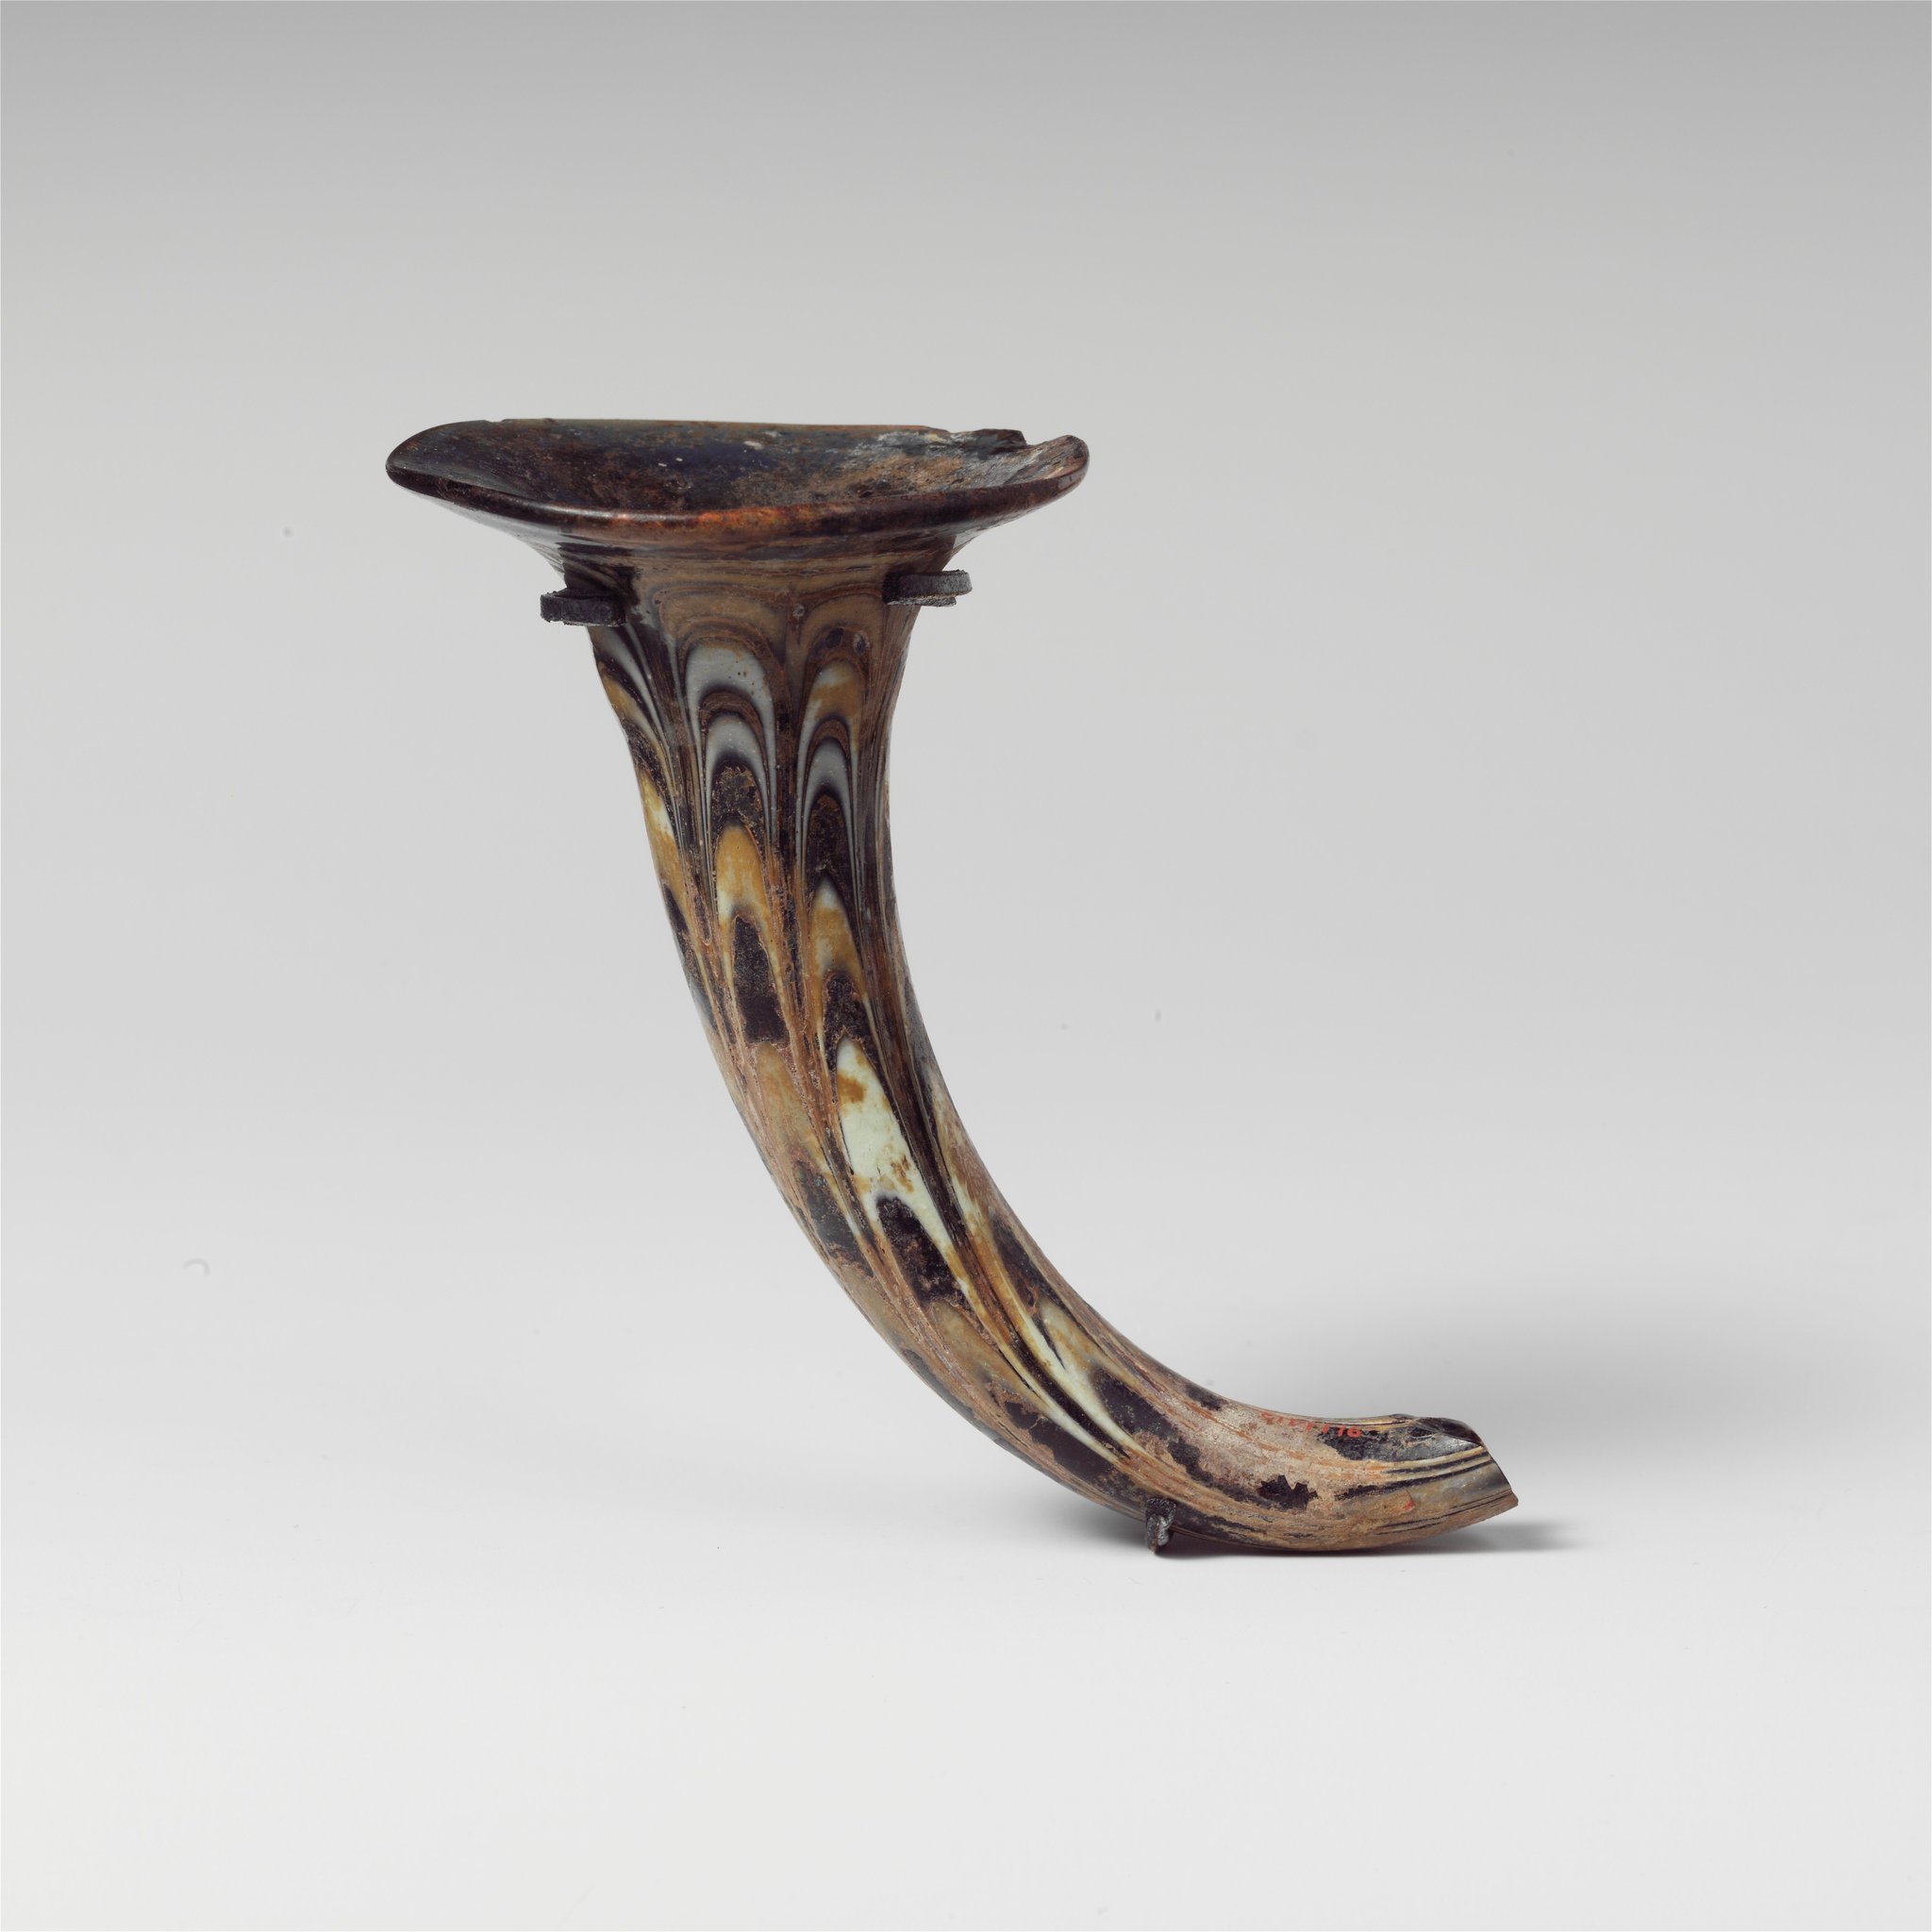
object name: horn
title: Glass horn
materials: glass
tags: horns